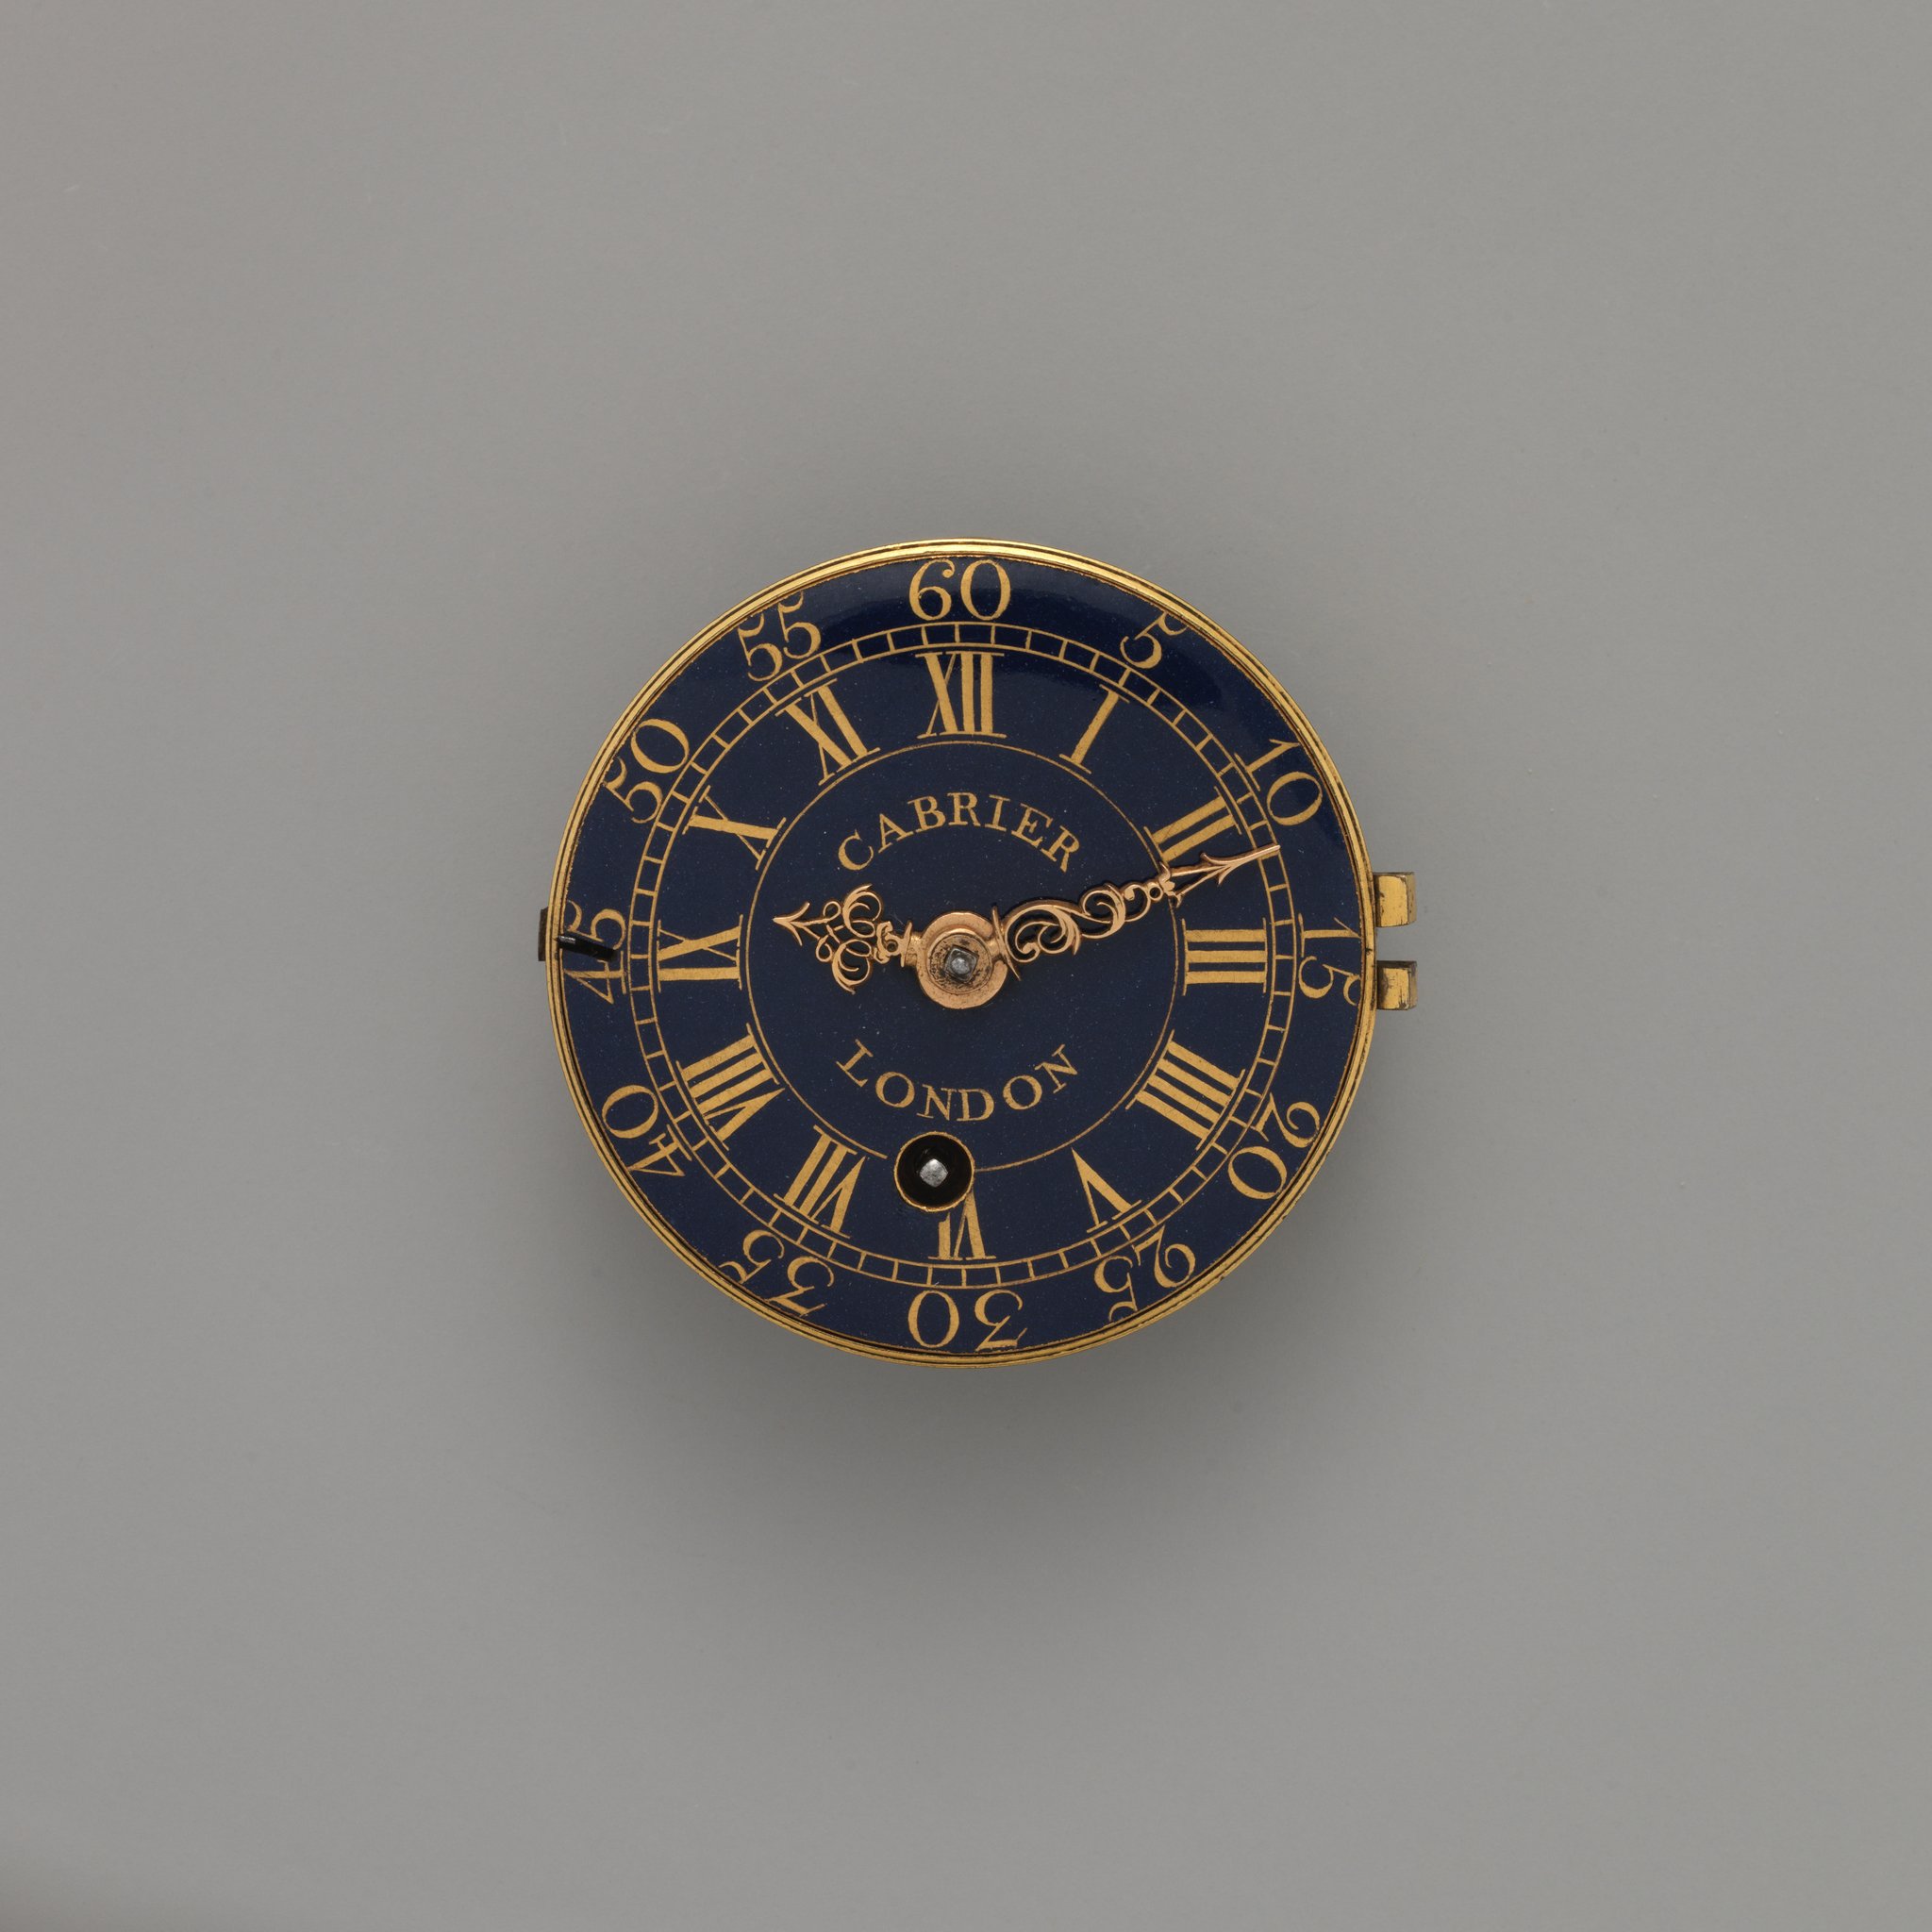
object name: watch movement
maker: charles cabrier ii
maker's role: maker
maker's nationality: british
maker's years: 1719-1776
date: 1740-1760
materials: enamel, gilt, metal, silver